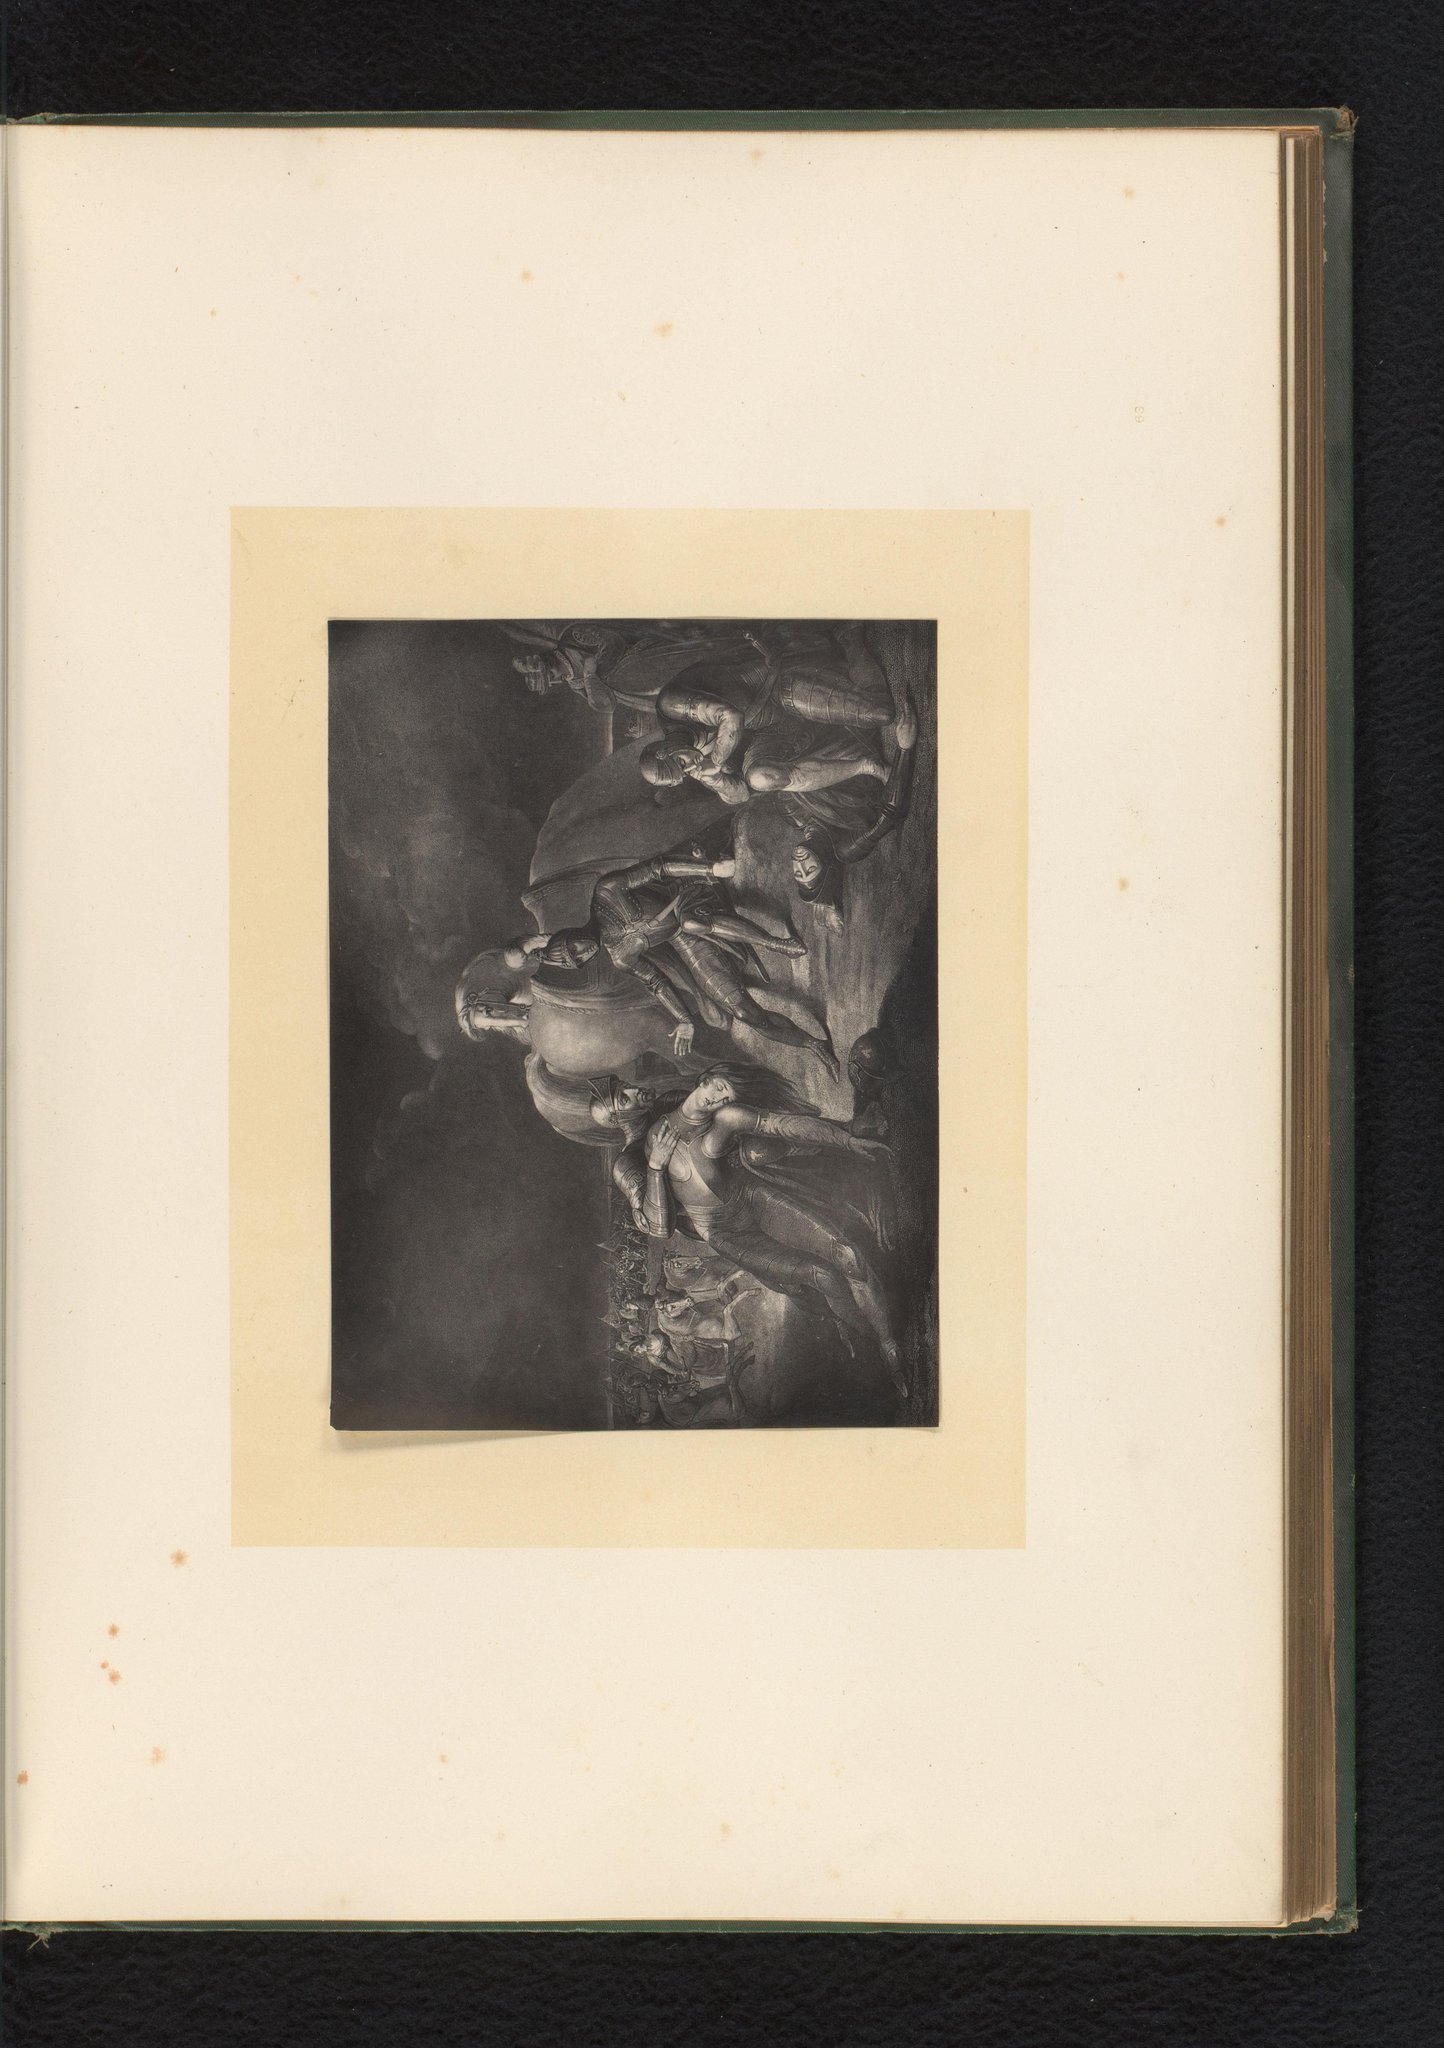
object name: photomechanical print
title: King Henry the Sixth, Act II, Scene 5: A Field of Battle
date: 1874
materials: paper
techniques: woodburytype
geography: london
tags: theatre, theatrical performance